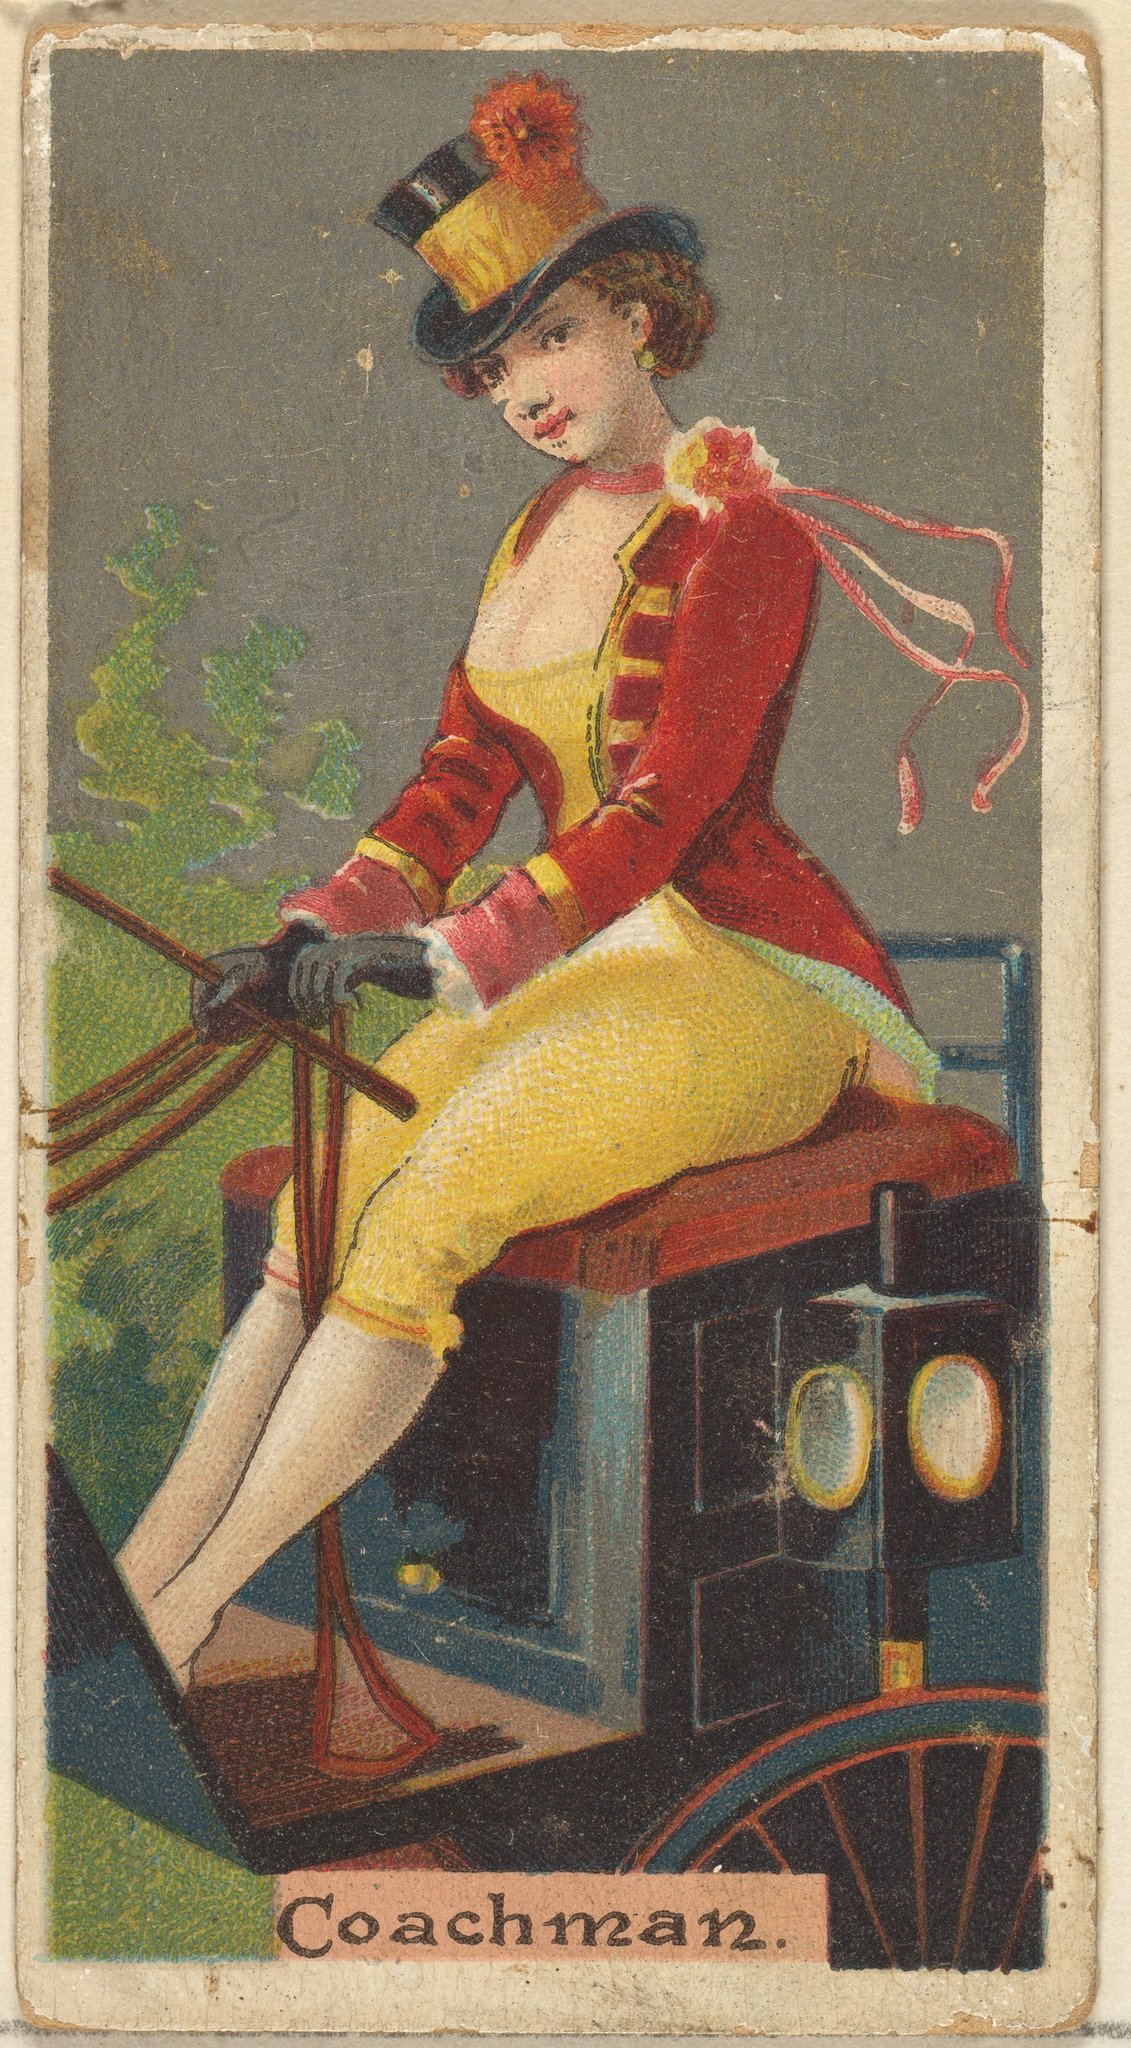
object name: print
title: Coachman, from the Occupations for Women series (N166) for Old Judge and Dogs Head Cigarettes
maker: goodwin & company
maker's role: publisher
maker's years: 1850-1950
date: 1887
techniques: color lithograph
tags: women